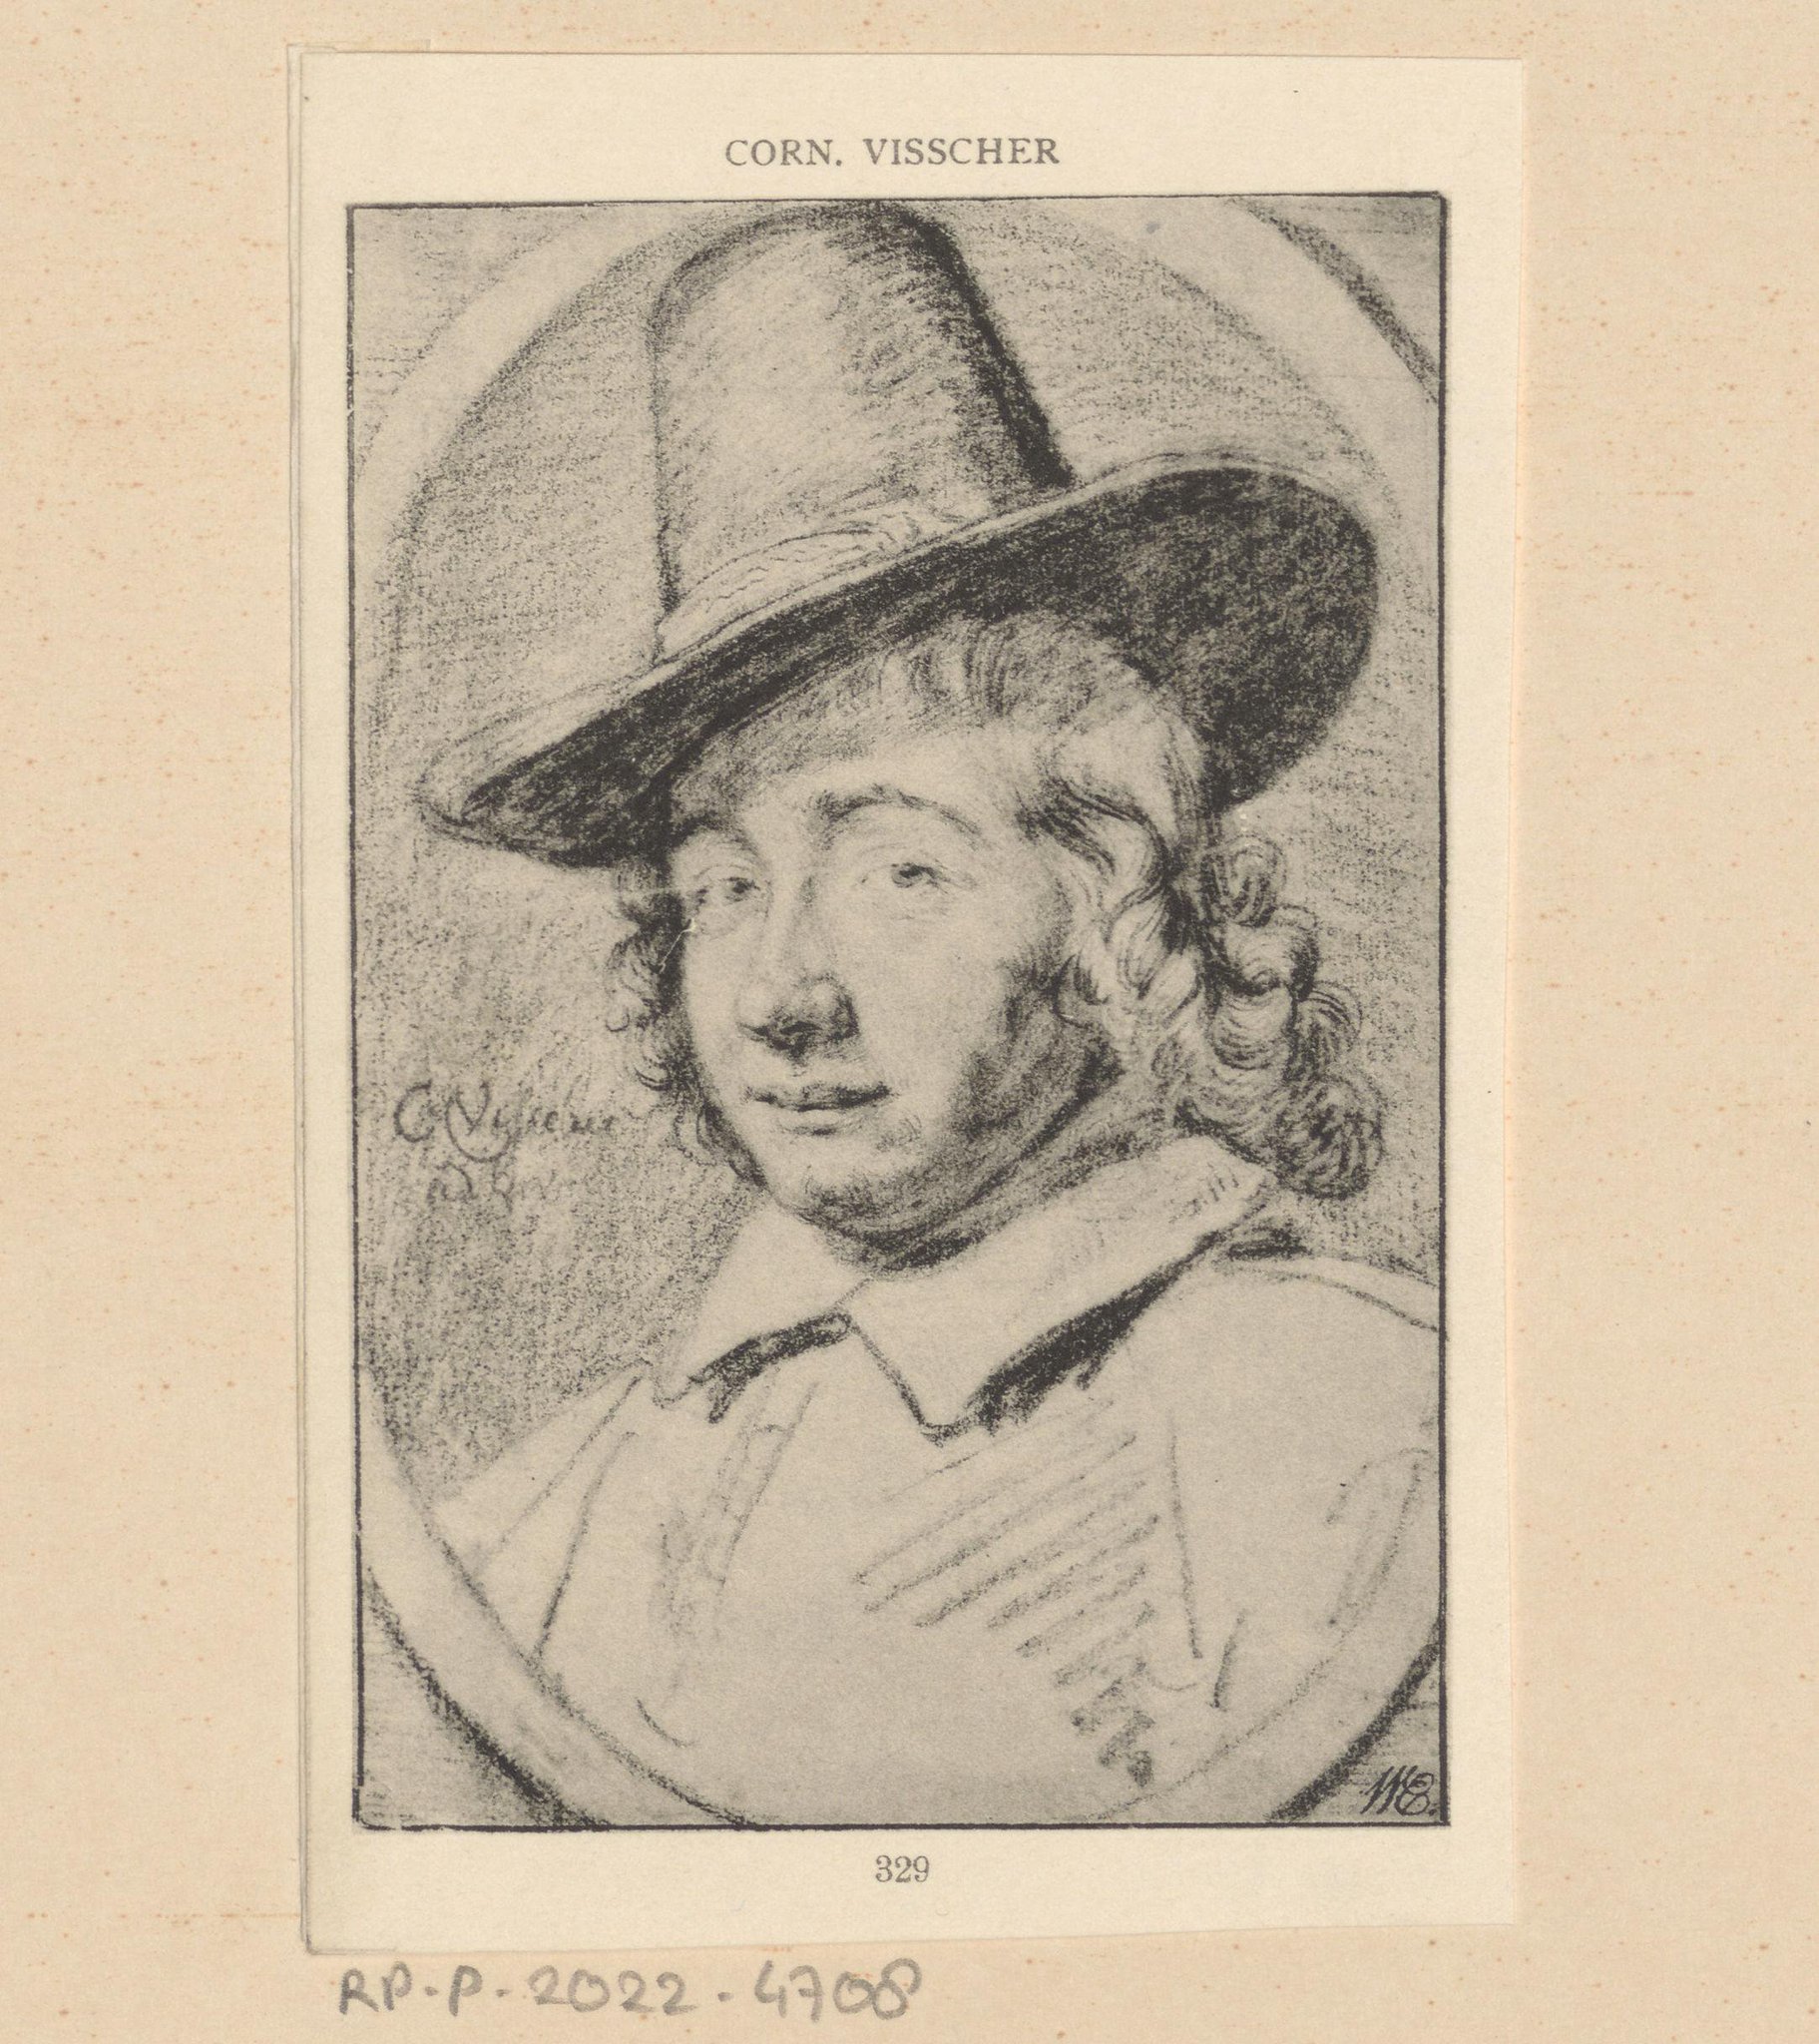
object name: photomechanical print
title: Portret van Cornelis Visscher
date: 1927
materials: paper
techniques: photograph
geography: haarlem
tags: haarlem, print maker, draughtsman, cornelis visscher (ii), historical persons, portrait, self-portrait of painter, portrait, self-portrait of graphic artist, portrait, self-portrait of draughtsman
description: Fotomechanische afdruk waarschijnlijk uit een veilingcatalogus van: Frederik Muller & Cie (1927/07/05 - 1927/07/06), lotnr. 329.